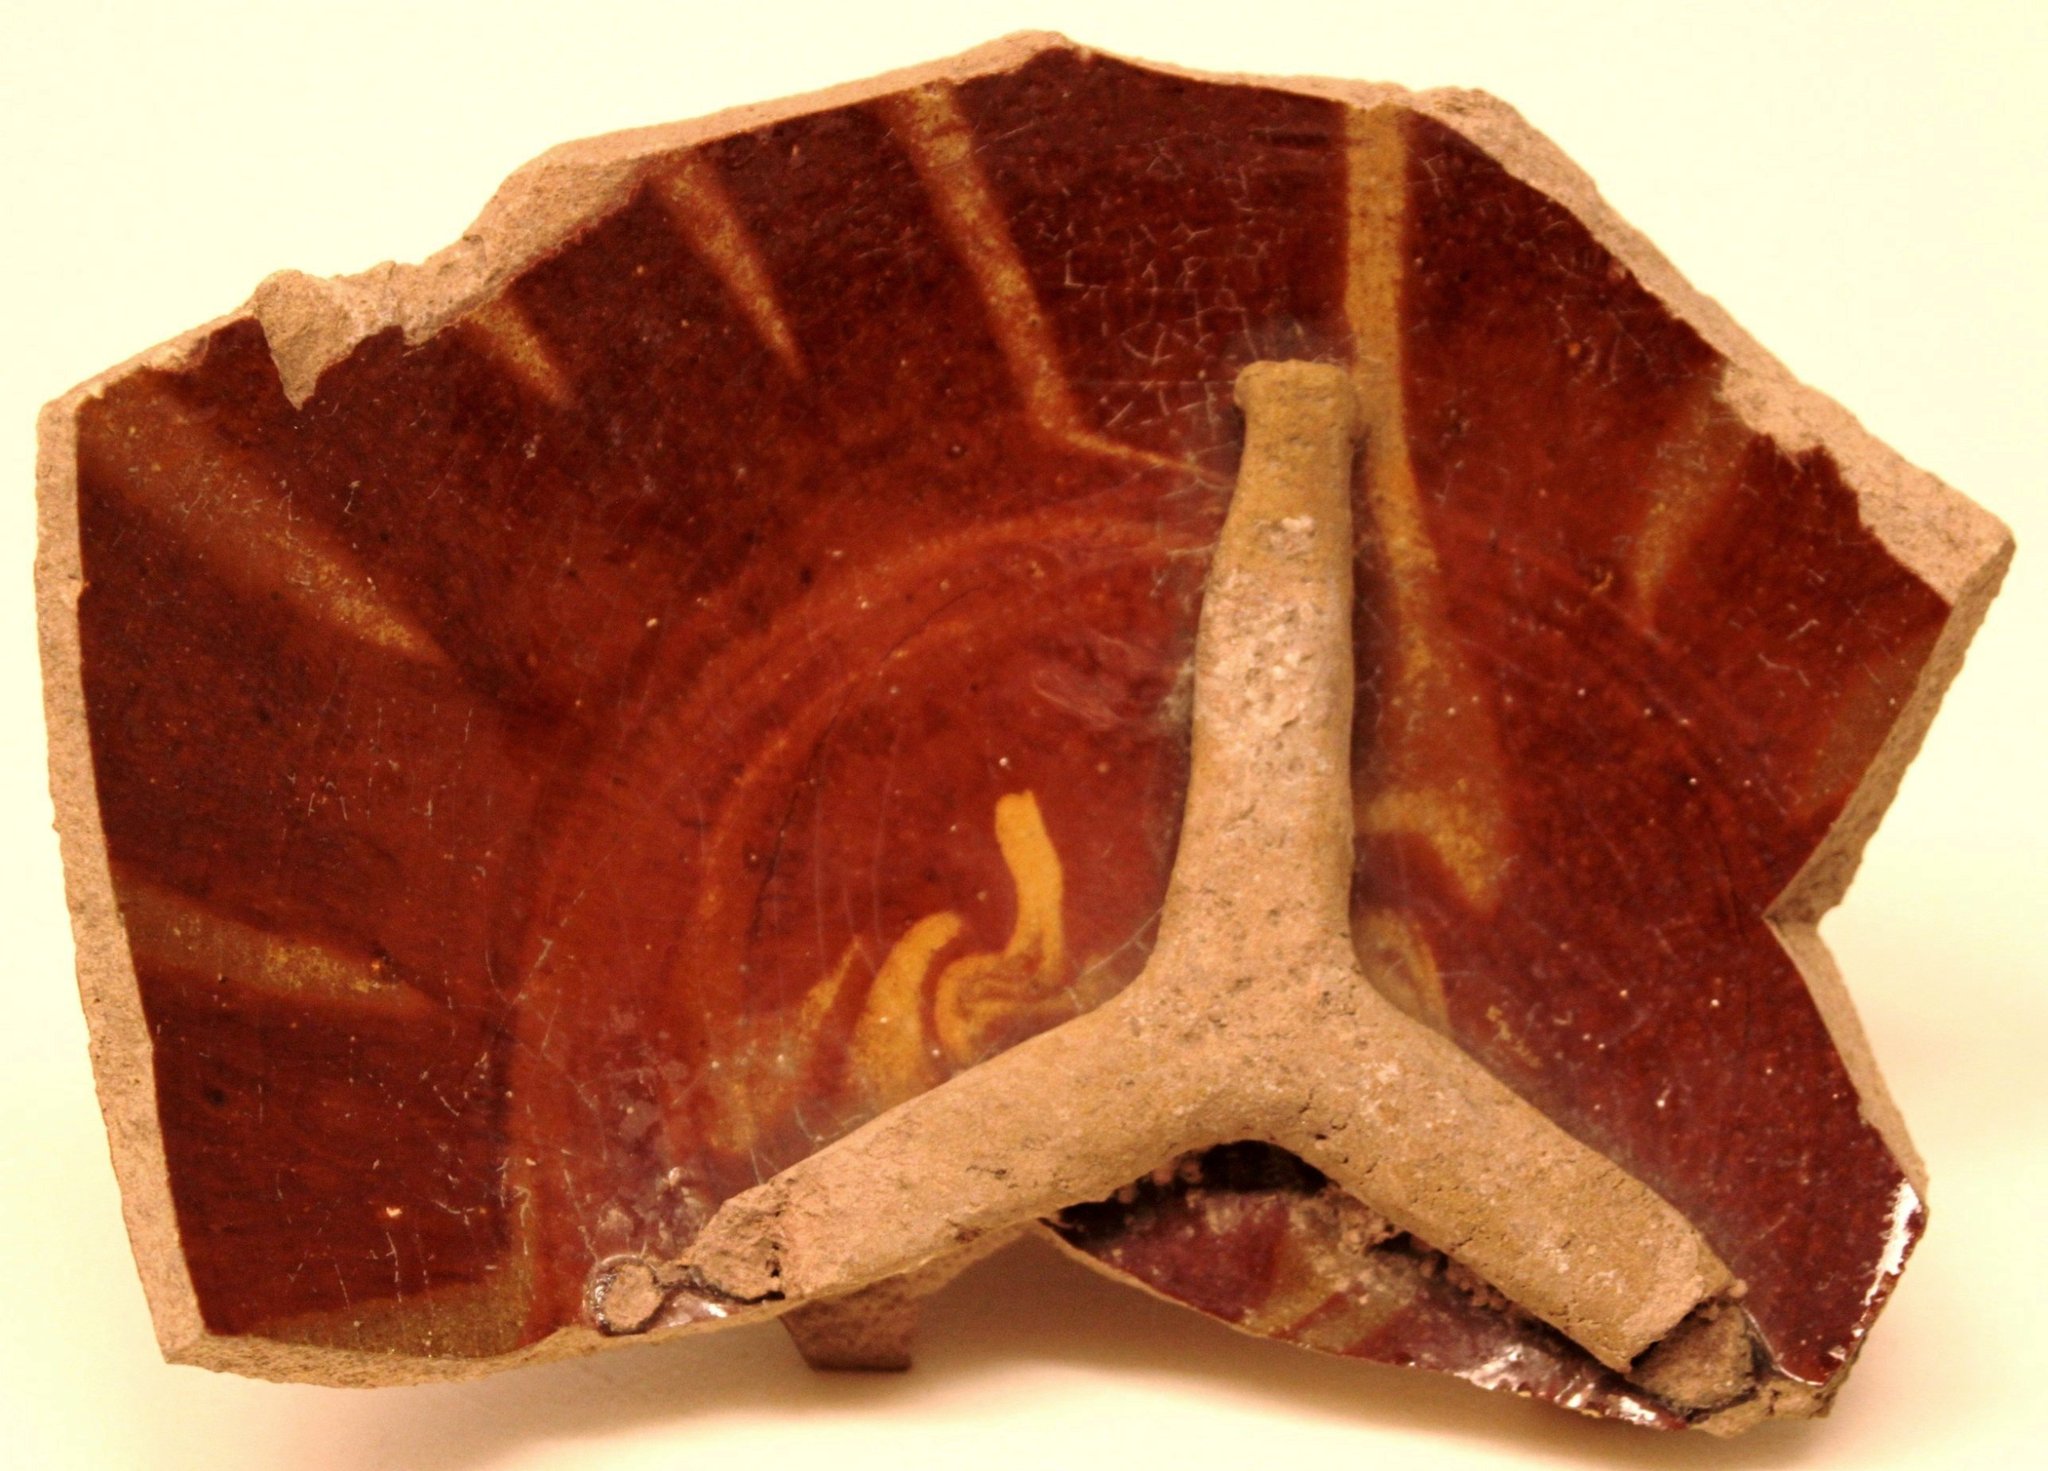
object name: waster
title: Waster of a Bowl with a Tripod Stuck Inside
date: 1501-1700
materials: earthenware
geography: iran